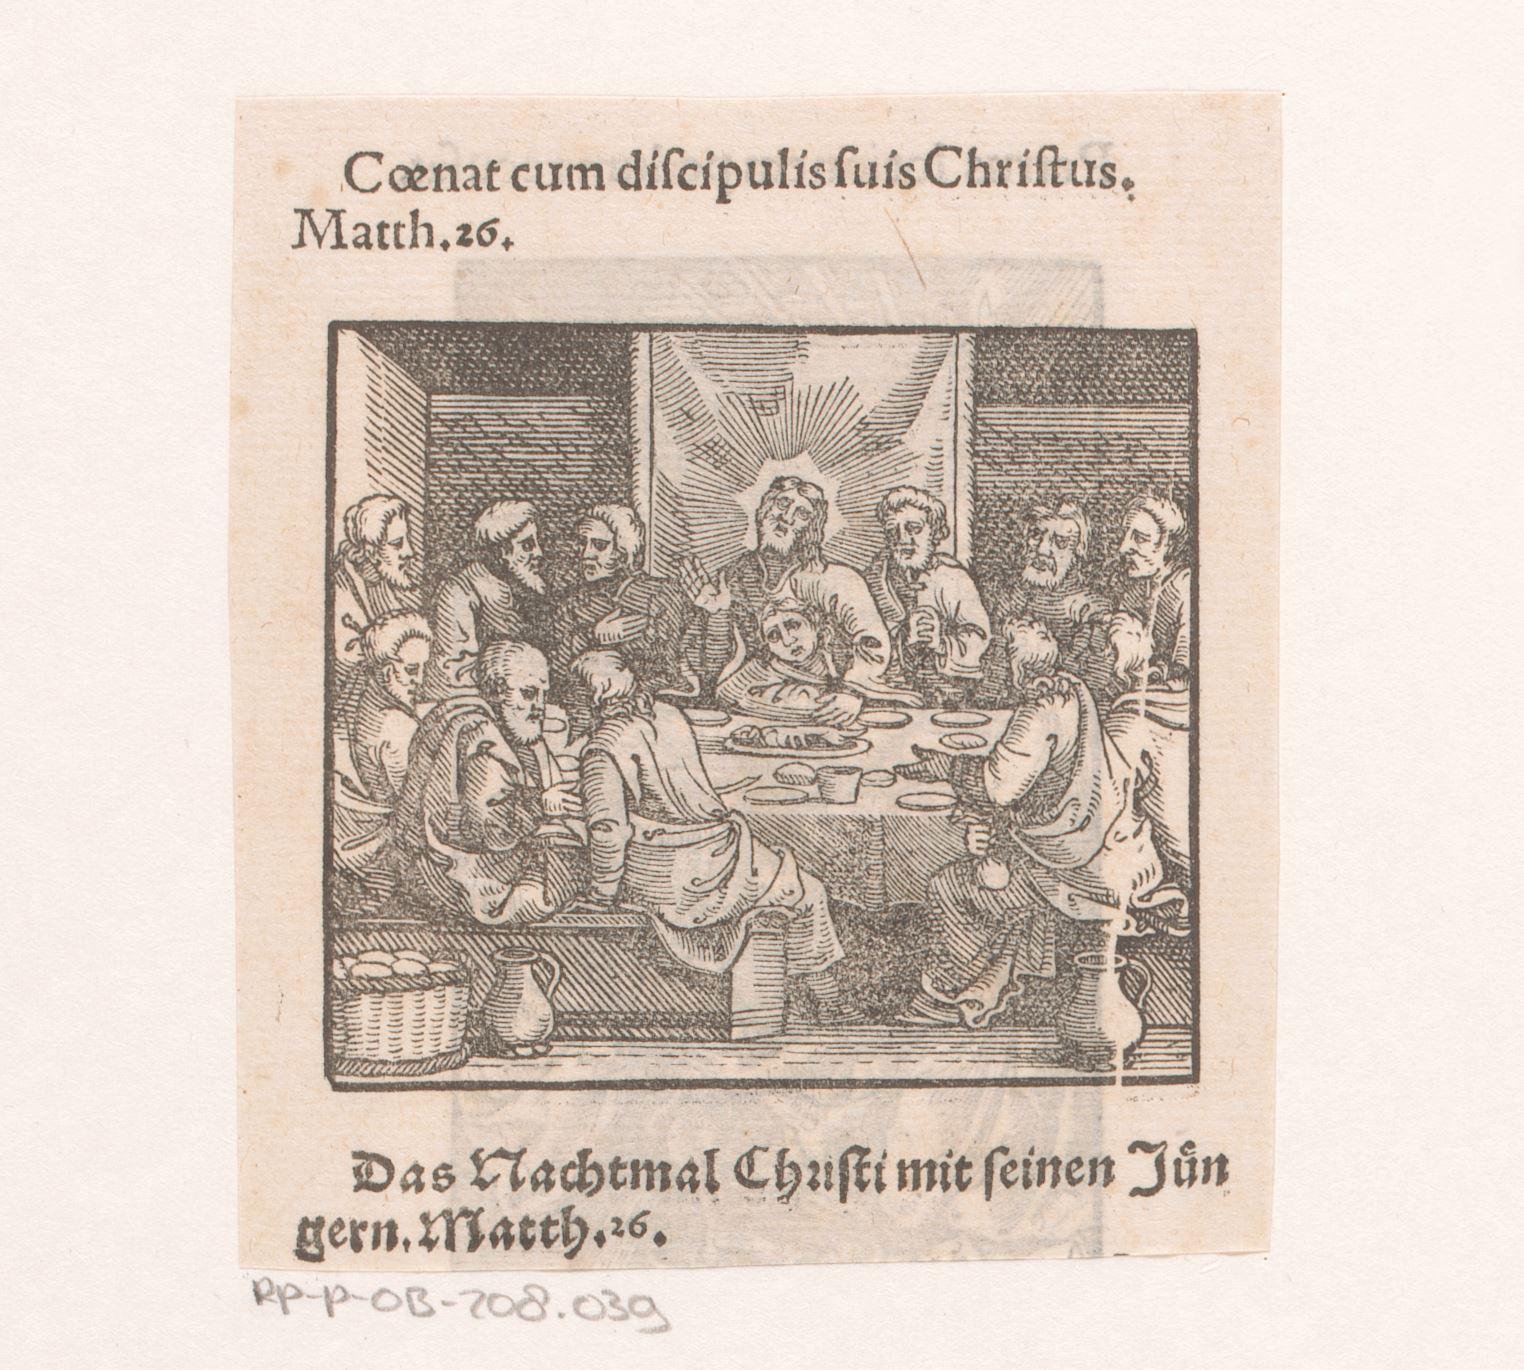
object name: book illustration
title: Laatste avondmaal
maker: Anonymous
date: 1600-1699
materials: paper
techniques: letterpress printing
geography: netherlands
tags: last supper (in general) (matthew 26:21-35; mark 14:18-31; luke 22:3, 22:15-23; john 13:21-38)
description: Christus zit tijdens het laatste avondmaal te midden van zijn discipelen. Johannes ligt tegen zijn borst. De discipelen reageren verbaasd op zijn uitspraak dat een van hen hem zal verraden. Judas houdt de zak met zilverstukken verborgen.